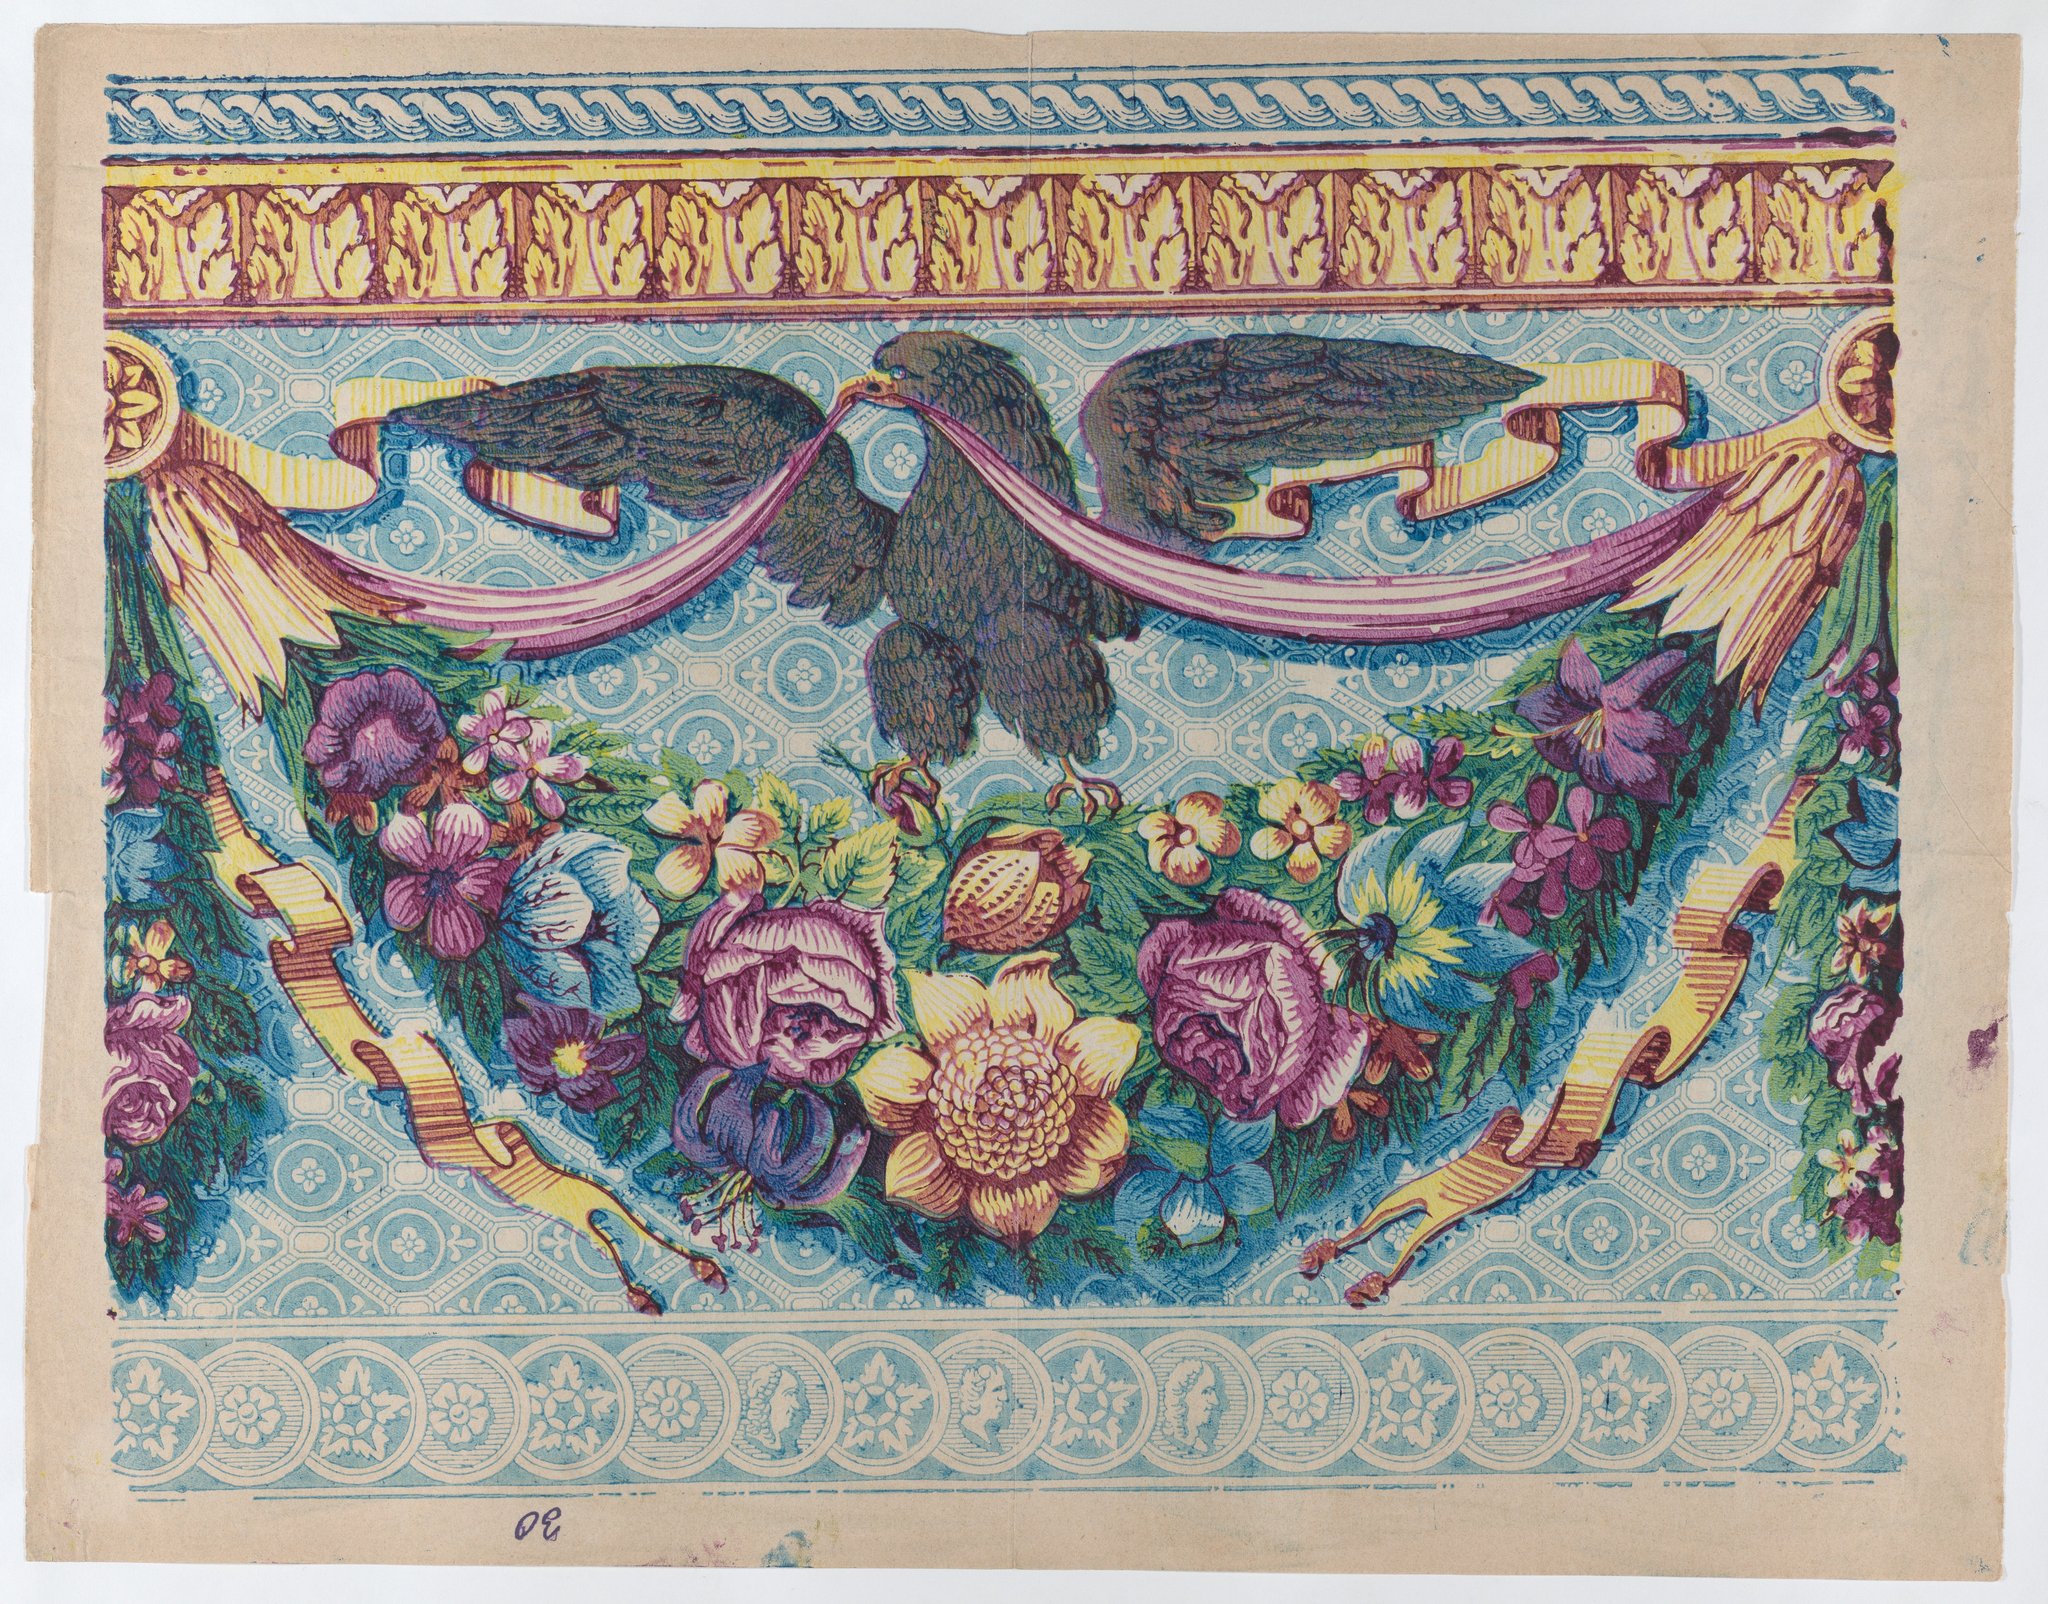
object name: print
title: Sheet with an eagle atop a festoon of flowers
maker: Anonymous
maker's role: artist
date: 1767-1866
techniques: relief print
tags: eagles,garlands